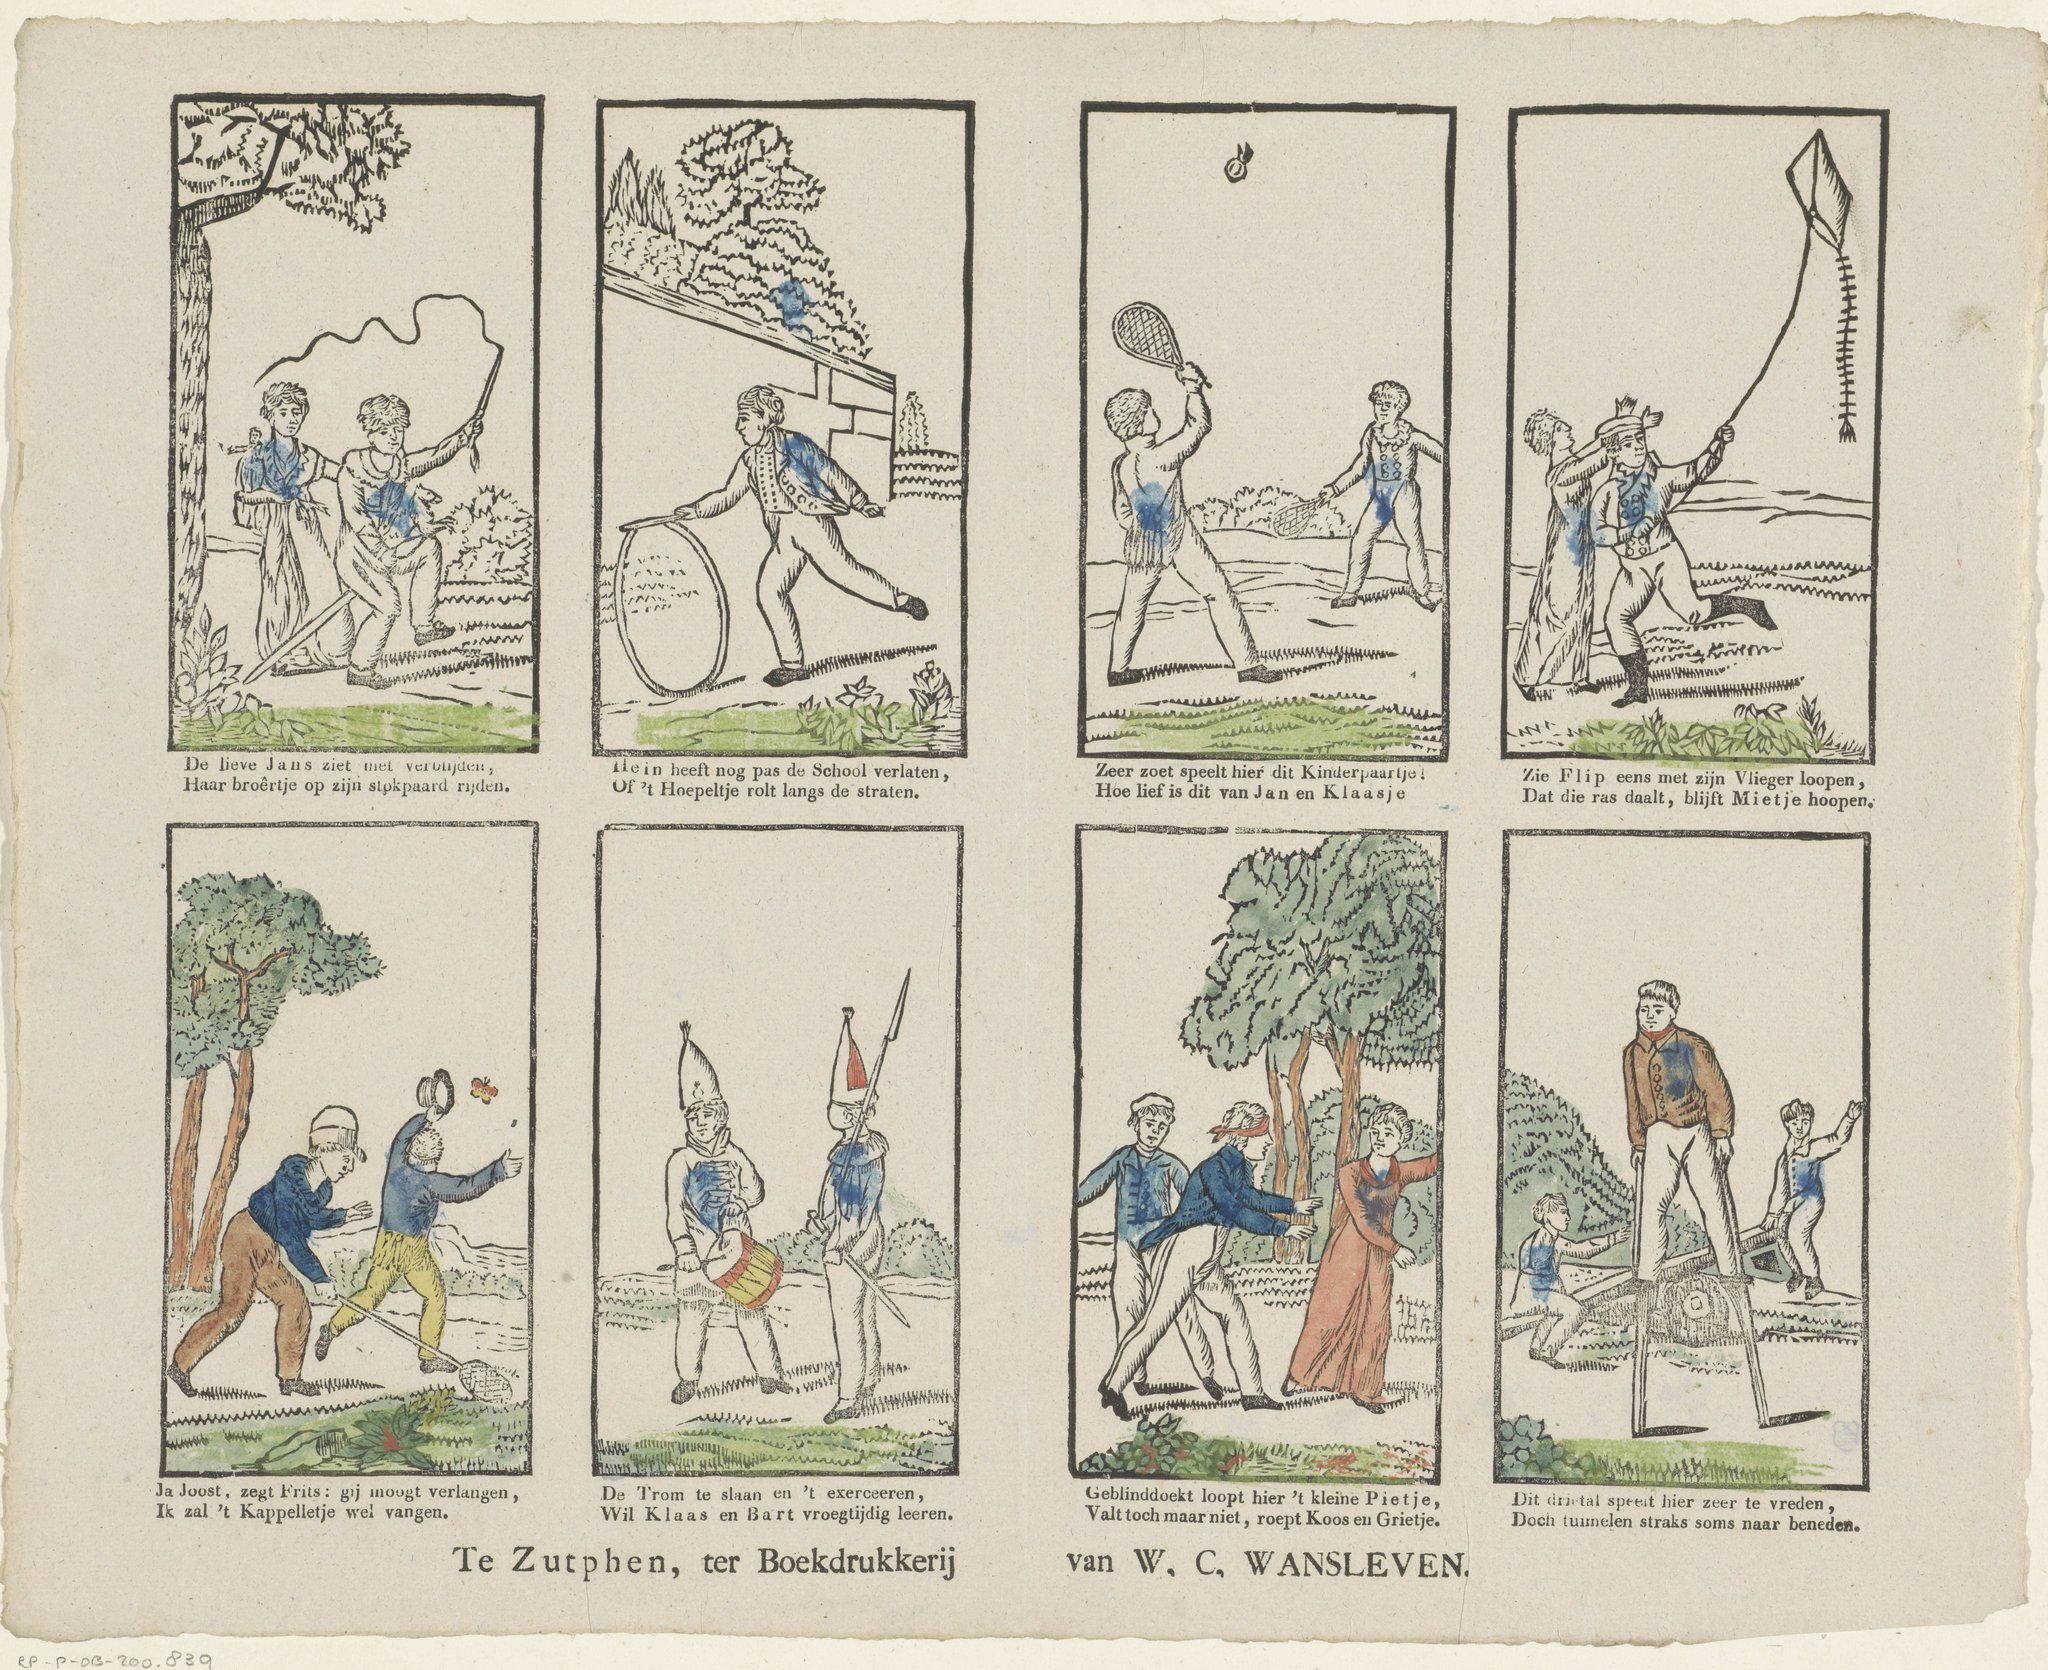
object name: print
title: Kinderspelen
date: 1806-1858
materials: paper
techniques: colour, letterpress printing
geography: netherlands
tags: tennis, lawn-tennis, children's games and plays, (flying a) kite, games using special objects (marbles, top, hoop, etc.)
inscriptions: collector's mark: Lugt 2760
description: Blad met 8 voorstellingen van kinderspelen, waaronder hoepelen, tennissen en vliegeren. Onder elke afbeelding een tweeregelig vers.